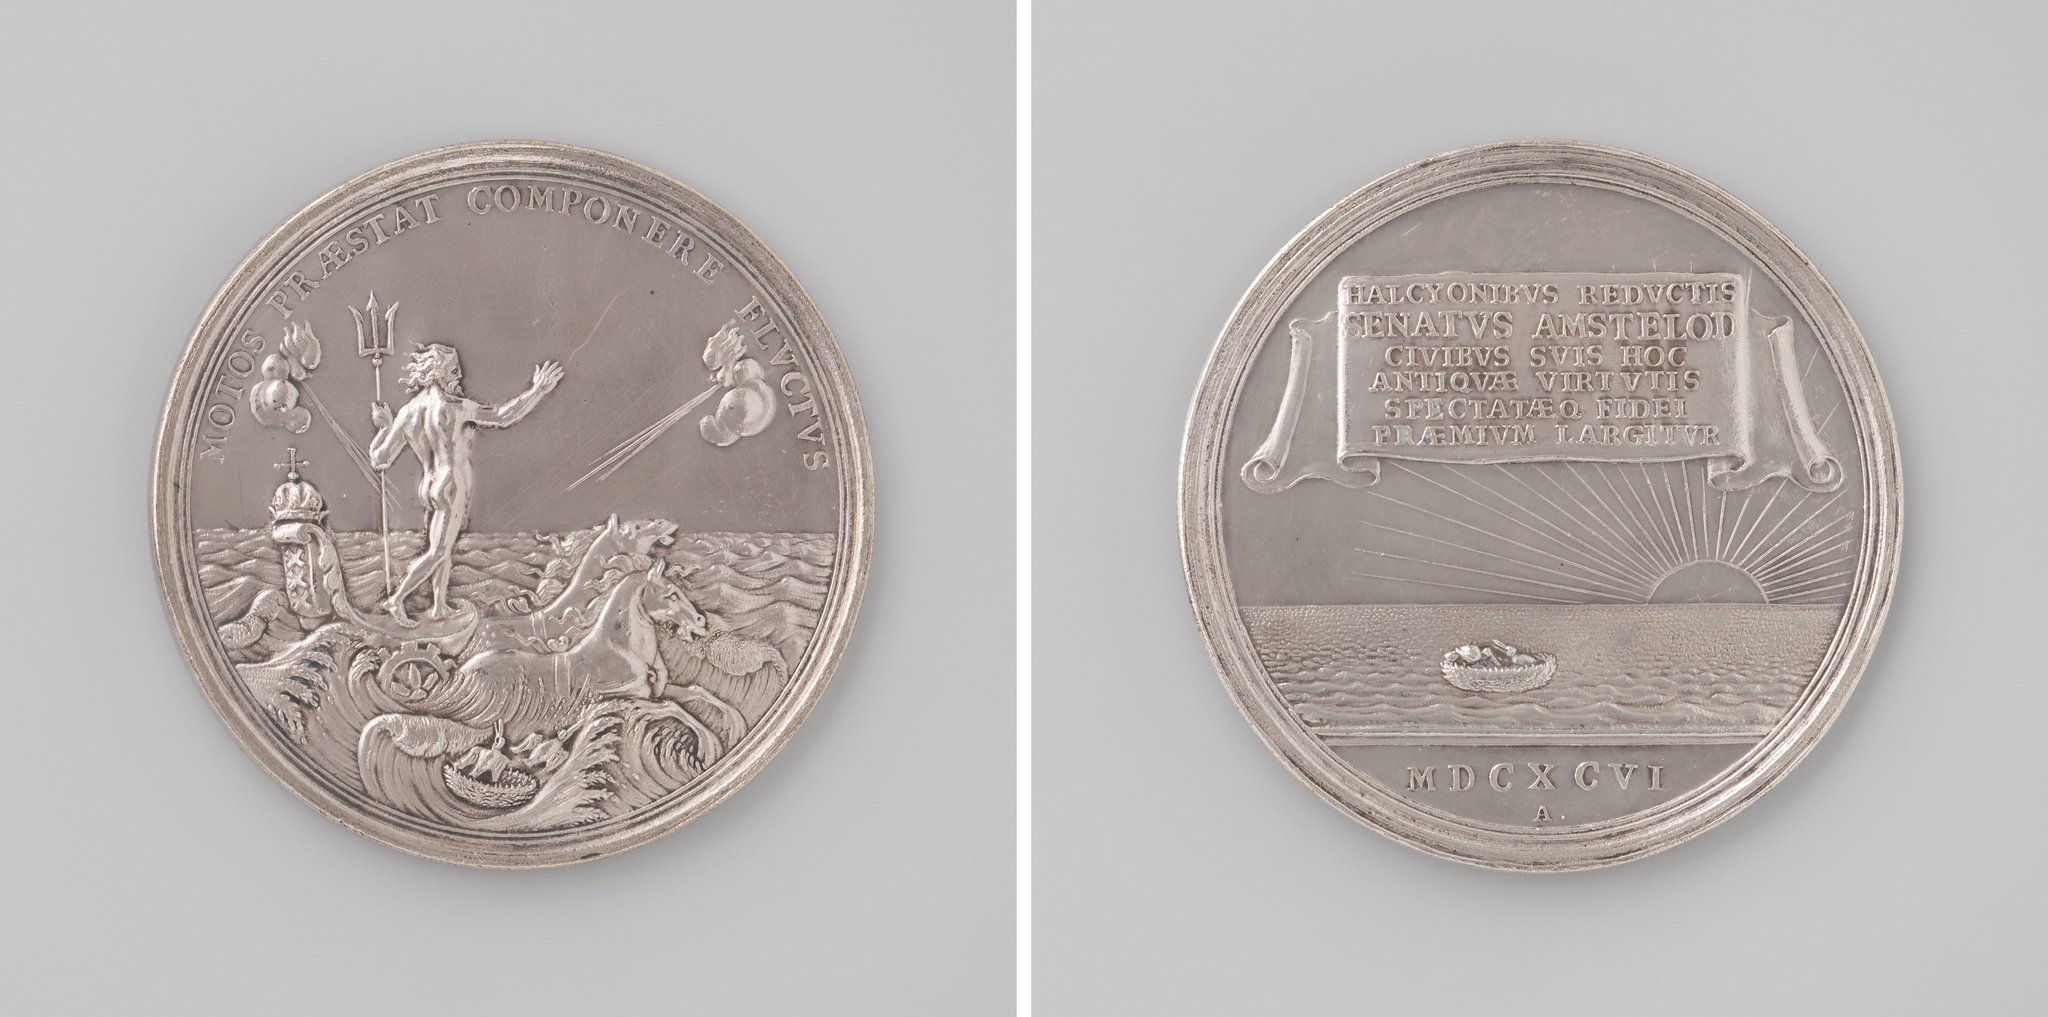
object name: history medal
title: Stillen van het aansprekersoproer te Amsterdam, penning aan de gewapende burgers vereerd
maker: reynier arondeaux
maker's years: 1678-1727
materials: silver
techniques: striking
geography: amsterdam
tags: amsterdam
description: Zilveren penning. Voorzijde: Neptunus met drietand staande op zijn wagen in een woelige zee straft vertoornd de losgelaten stormwinden, op voorgrond twee vogels die uit nest vallen binnen omschrift. Keerzijde: twee vogels in nest op kalme zee, terwijl zon opkomt onder wimpel met opschrift; afsnede: jaartal.